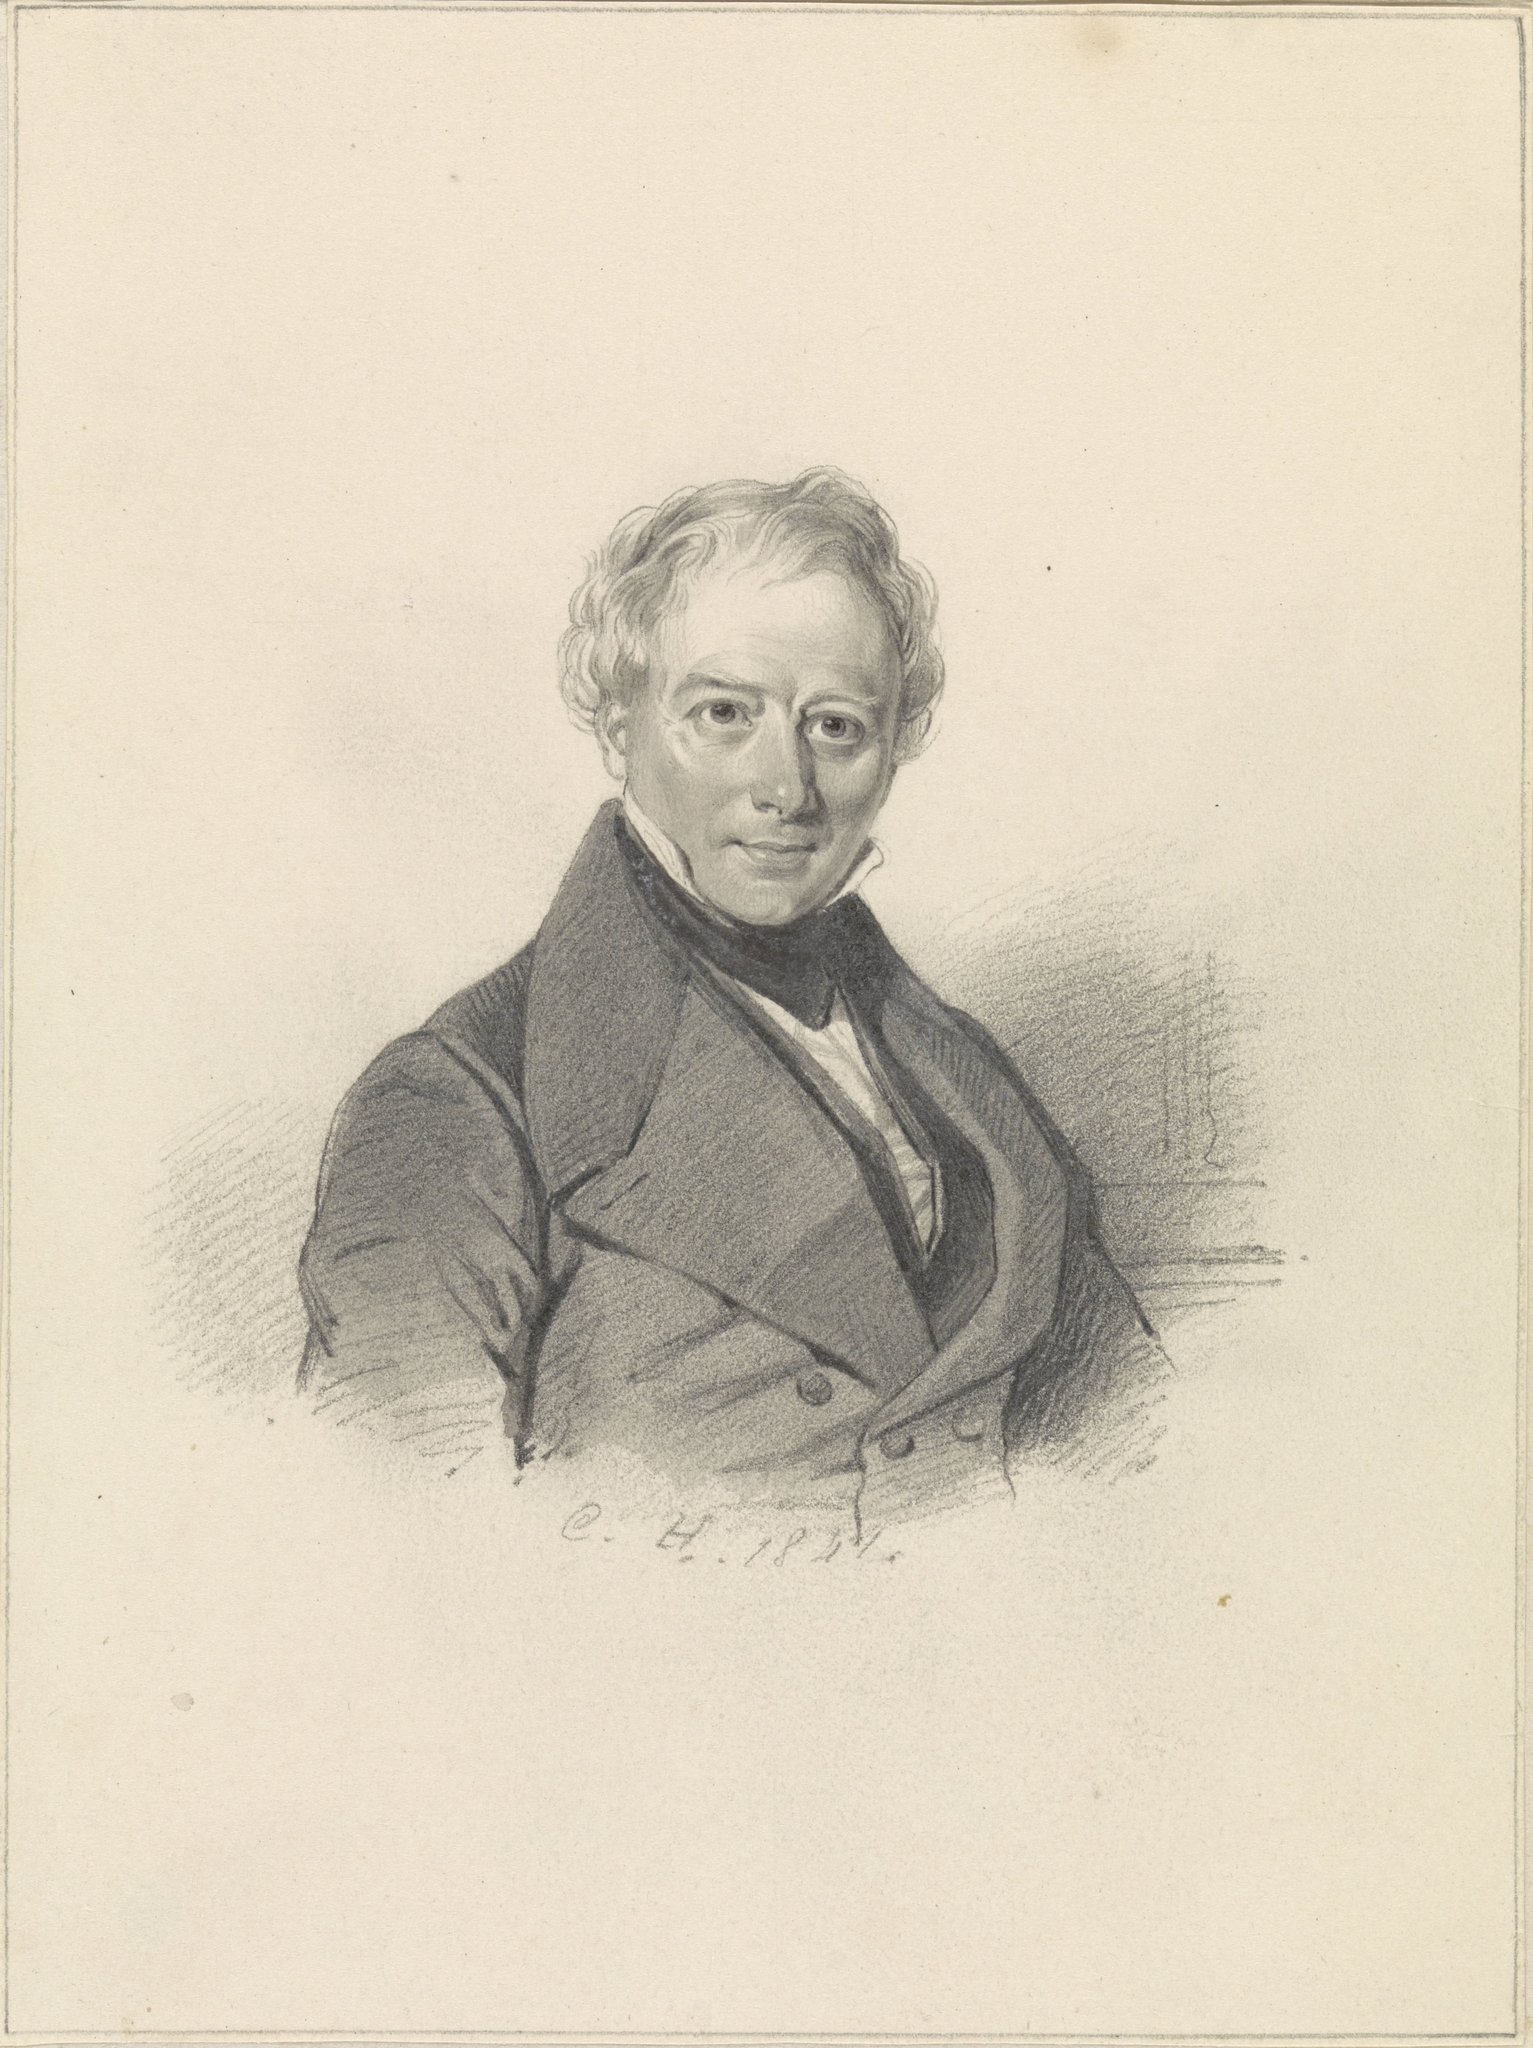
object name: drawing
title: Portret van Albertus Brondgeest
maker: coenraad hamburger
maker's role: draughtsman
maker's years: 1809-1891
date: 1841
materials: ink, paper, pencil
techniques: pen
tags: amsterdam, print maker, draughtsman, albertus brondgeest, historical persons, portrait, self-portrait of painter, portrait, self-portrait of artist, portrait, self-portrait of draughtsman